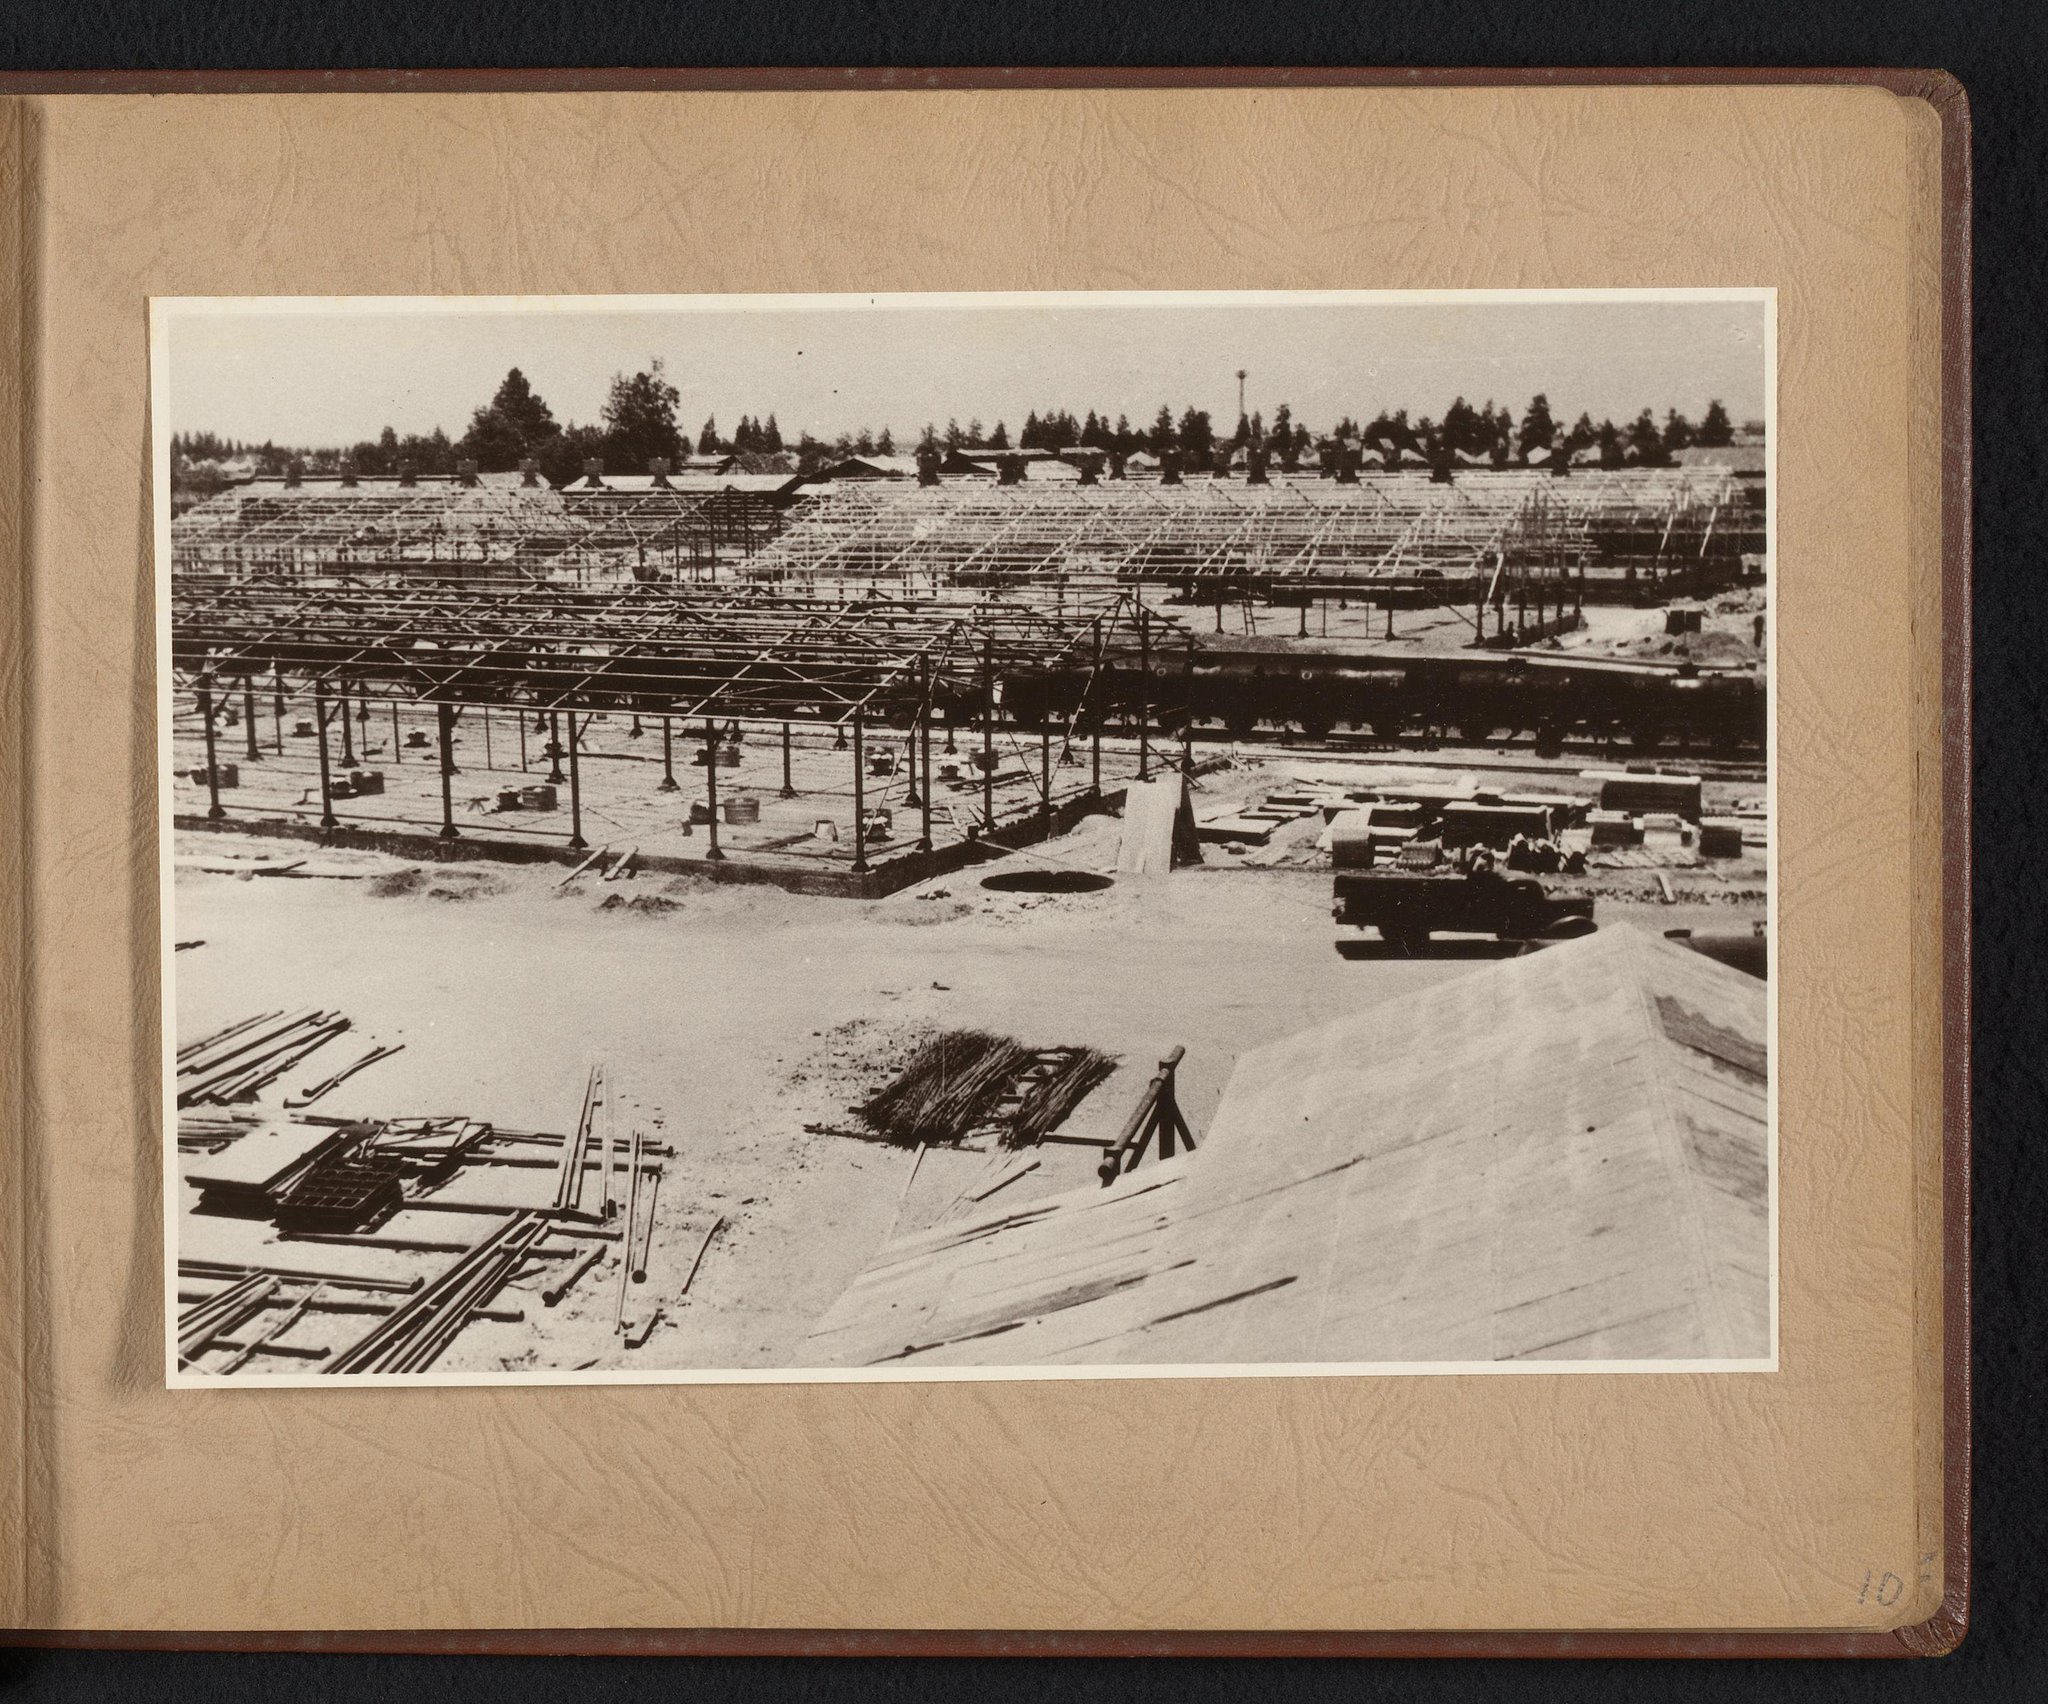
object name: photograph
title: Gebouwen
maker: Anonymous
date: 1936-1953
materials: cardboard, photographic support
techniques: gelatin silver print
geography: surabaya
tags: making the overground structures (~ building activities), oil; oil refinery, surabaya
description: Albumblad met een foto van de bouw van opslagloodsen en werkplaatsen op het terrein Bandaran te Surabaya van de B.P.M. (Bataafsche Petroleum Maatschappij). Onderdeel van het fotoalbum van de N.V. Machinefabriek Braat te Soerabaja met foto's van verschillende producten voor de industrie uit de periode 1936-1953.